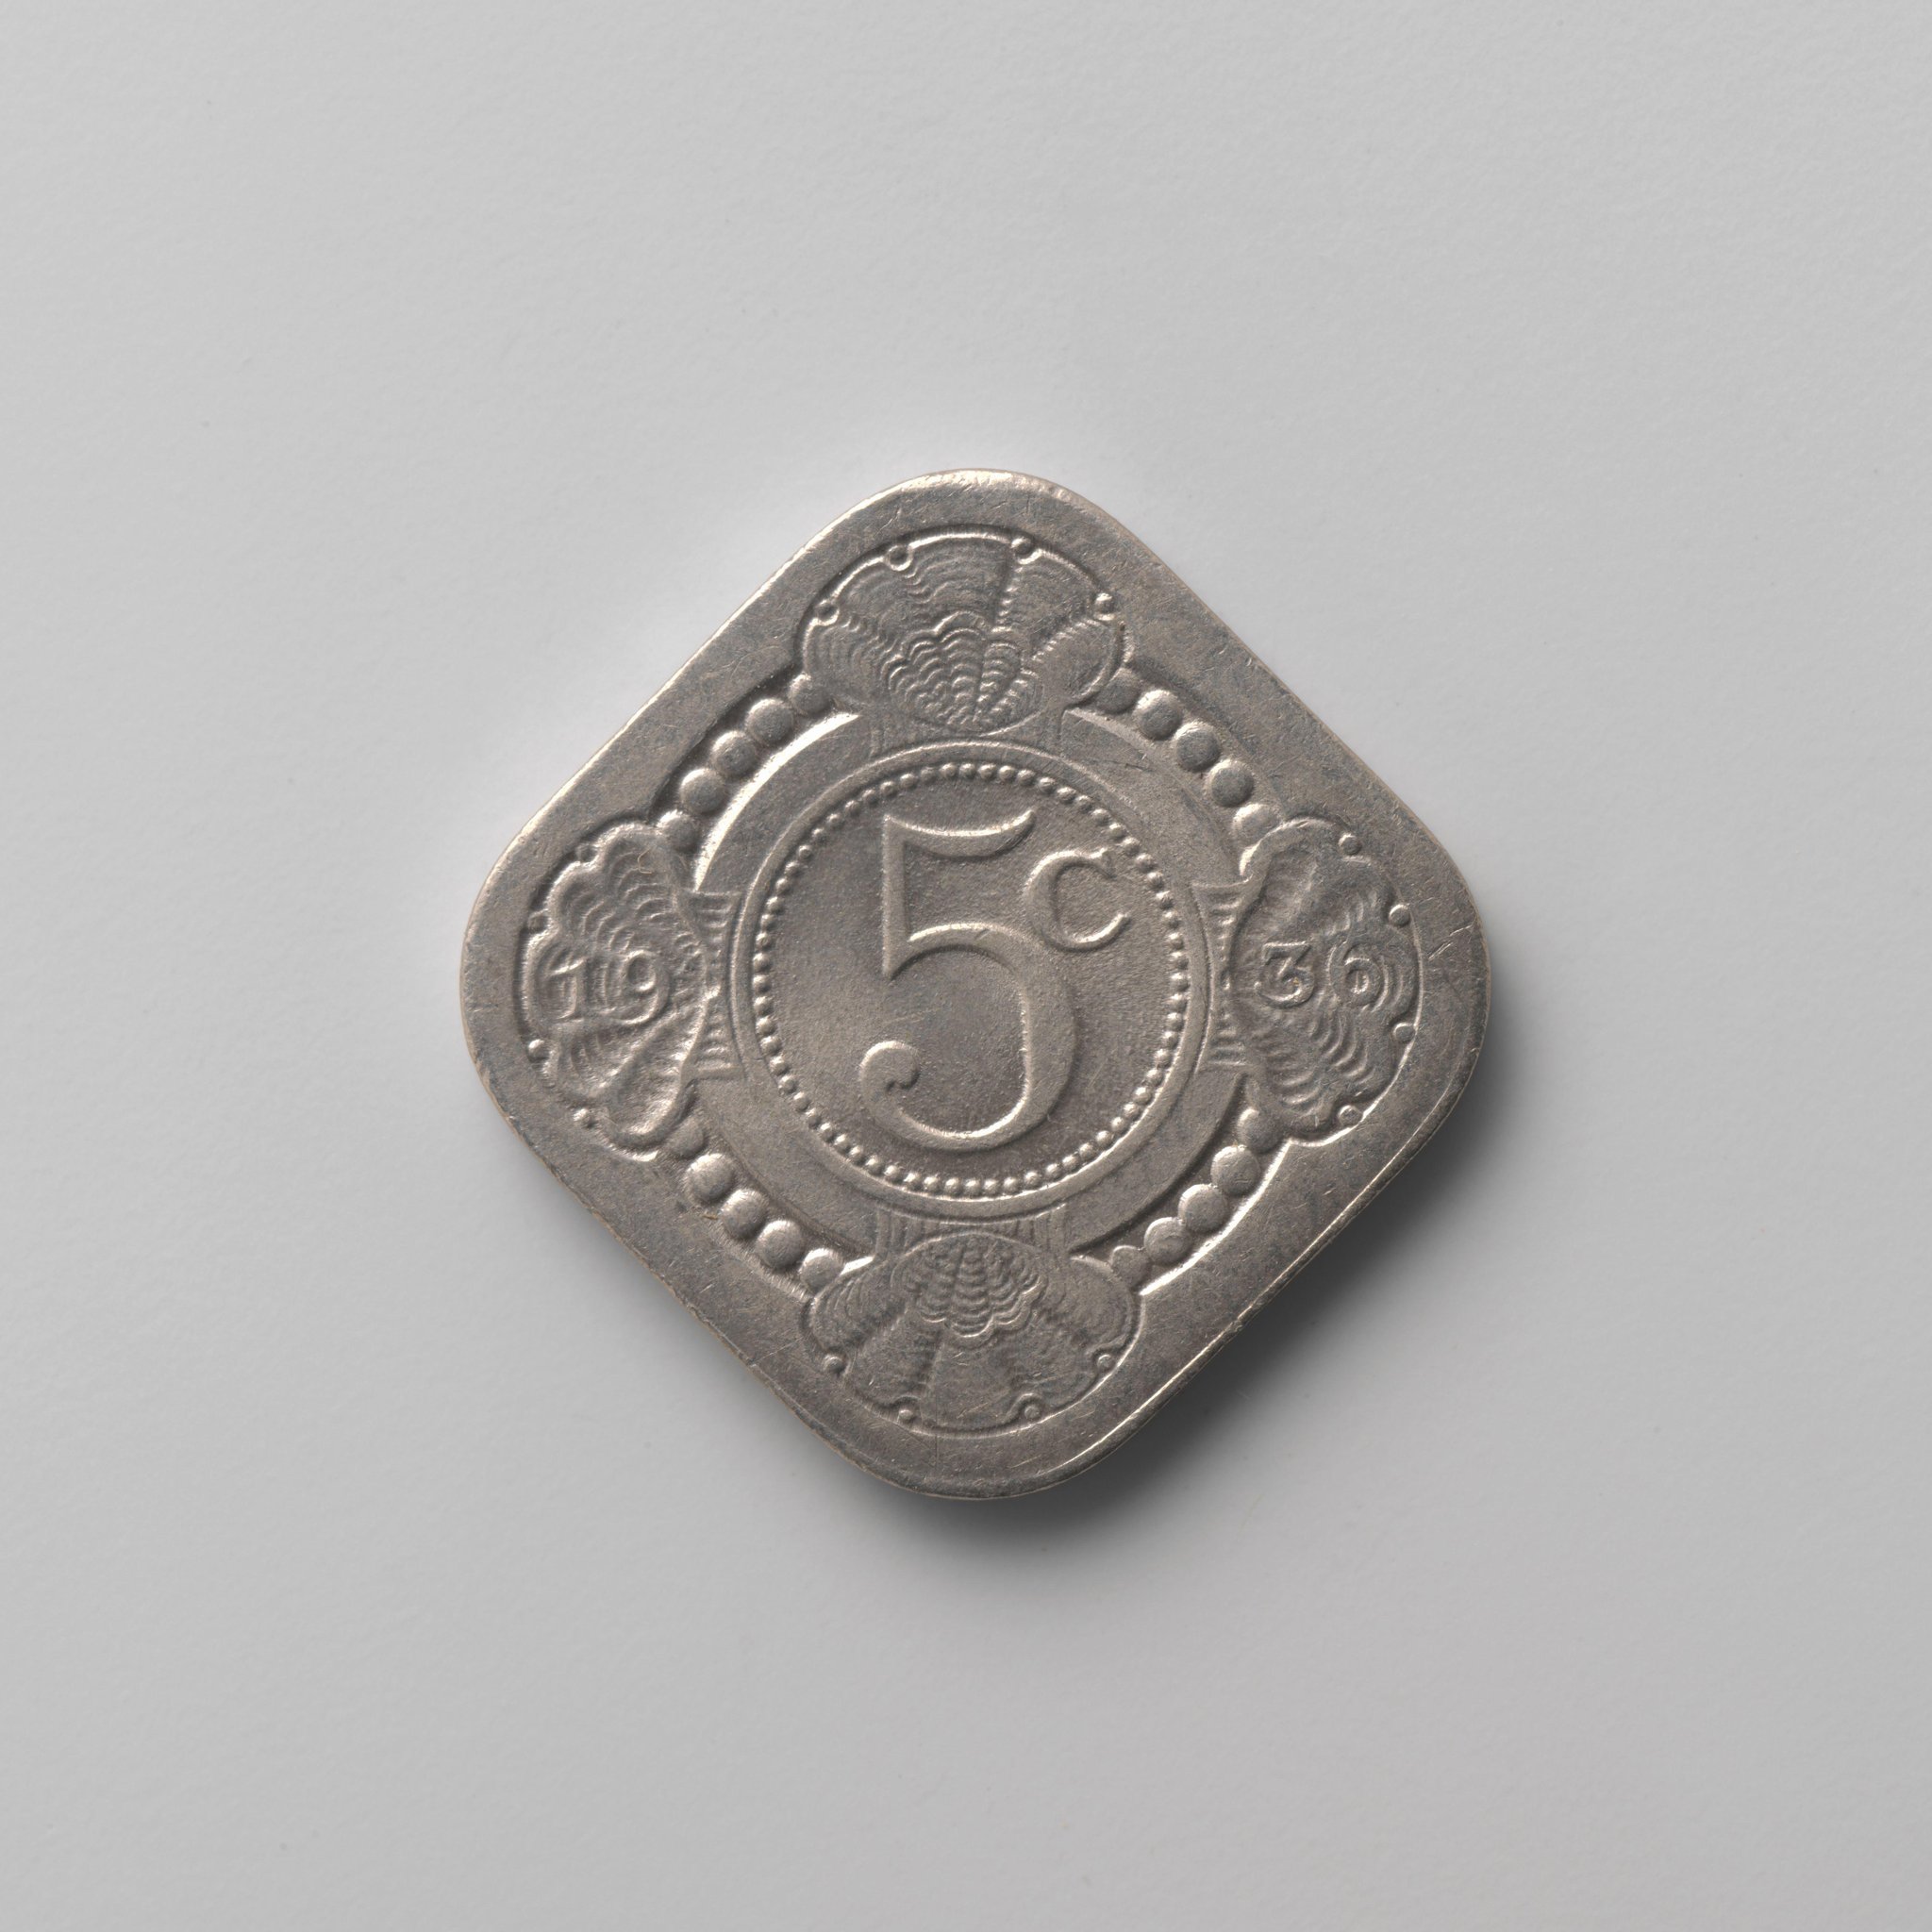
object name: coin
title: Nederland, 5 cent,1936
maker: wilhelmina of the netherlands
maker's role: print maker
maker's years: 1880-1962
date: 1936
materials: nickel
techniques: striking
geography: utrecht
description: Vierkante nikkelen munt. Voorzijde: in hoeken versiering, daarbinnen twee cirkels, waarin landsaanduiding. Daarbinnen vruchtdragende tak van een oranje-appel. Keerzijde: in de vier hoeken schelpen-versiering, verbonden door parels. Daarbinnen waarde-aanduiding 5 C in parelrand. Jaartal in de twee schelpen links en rechts. Gladde rand.